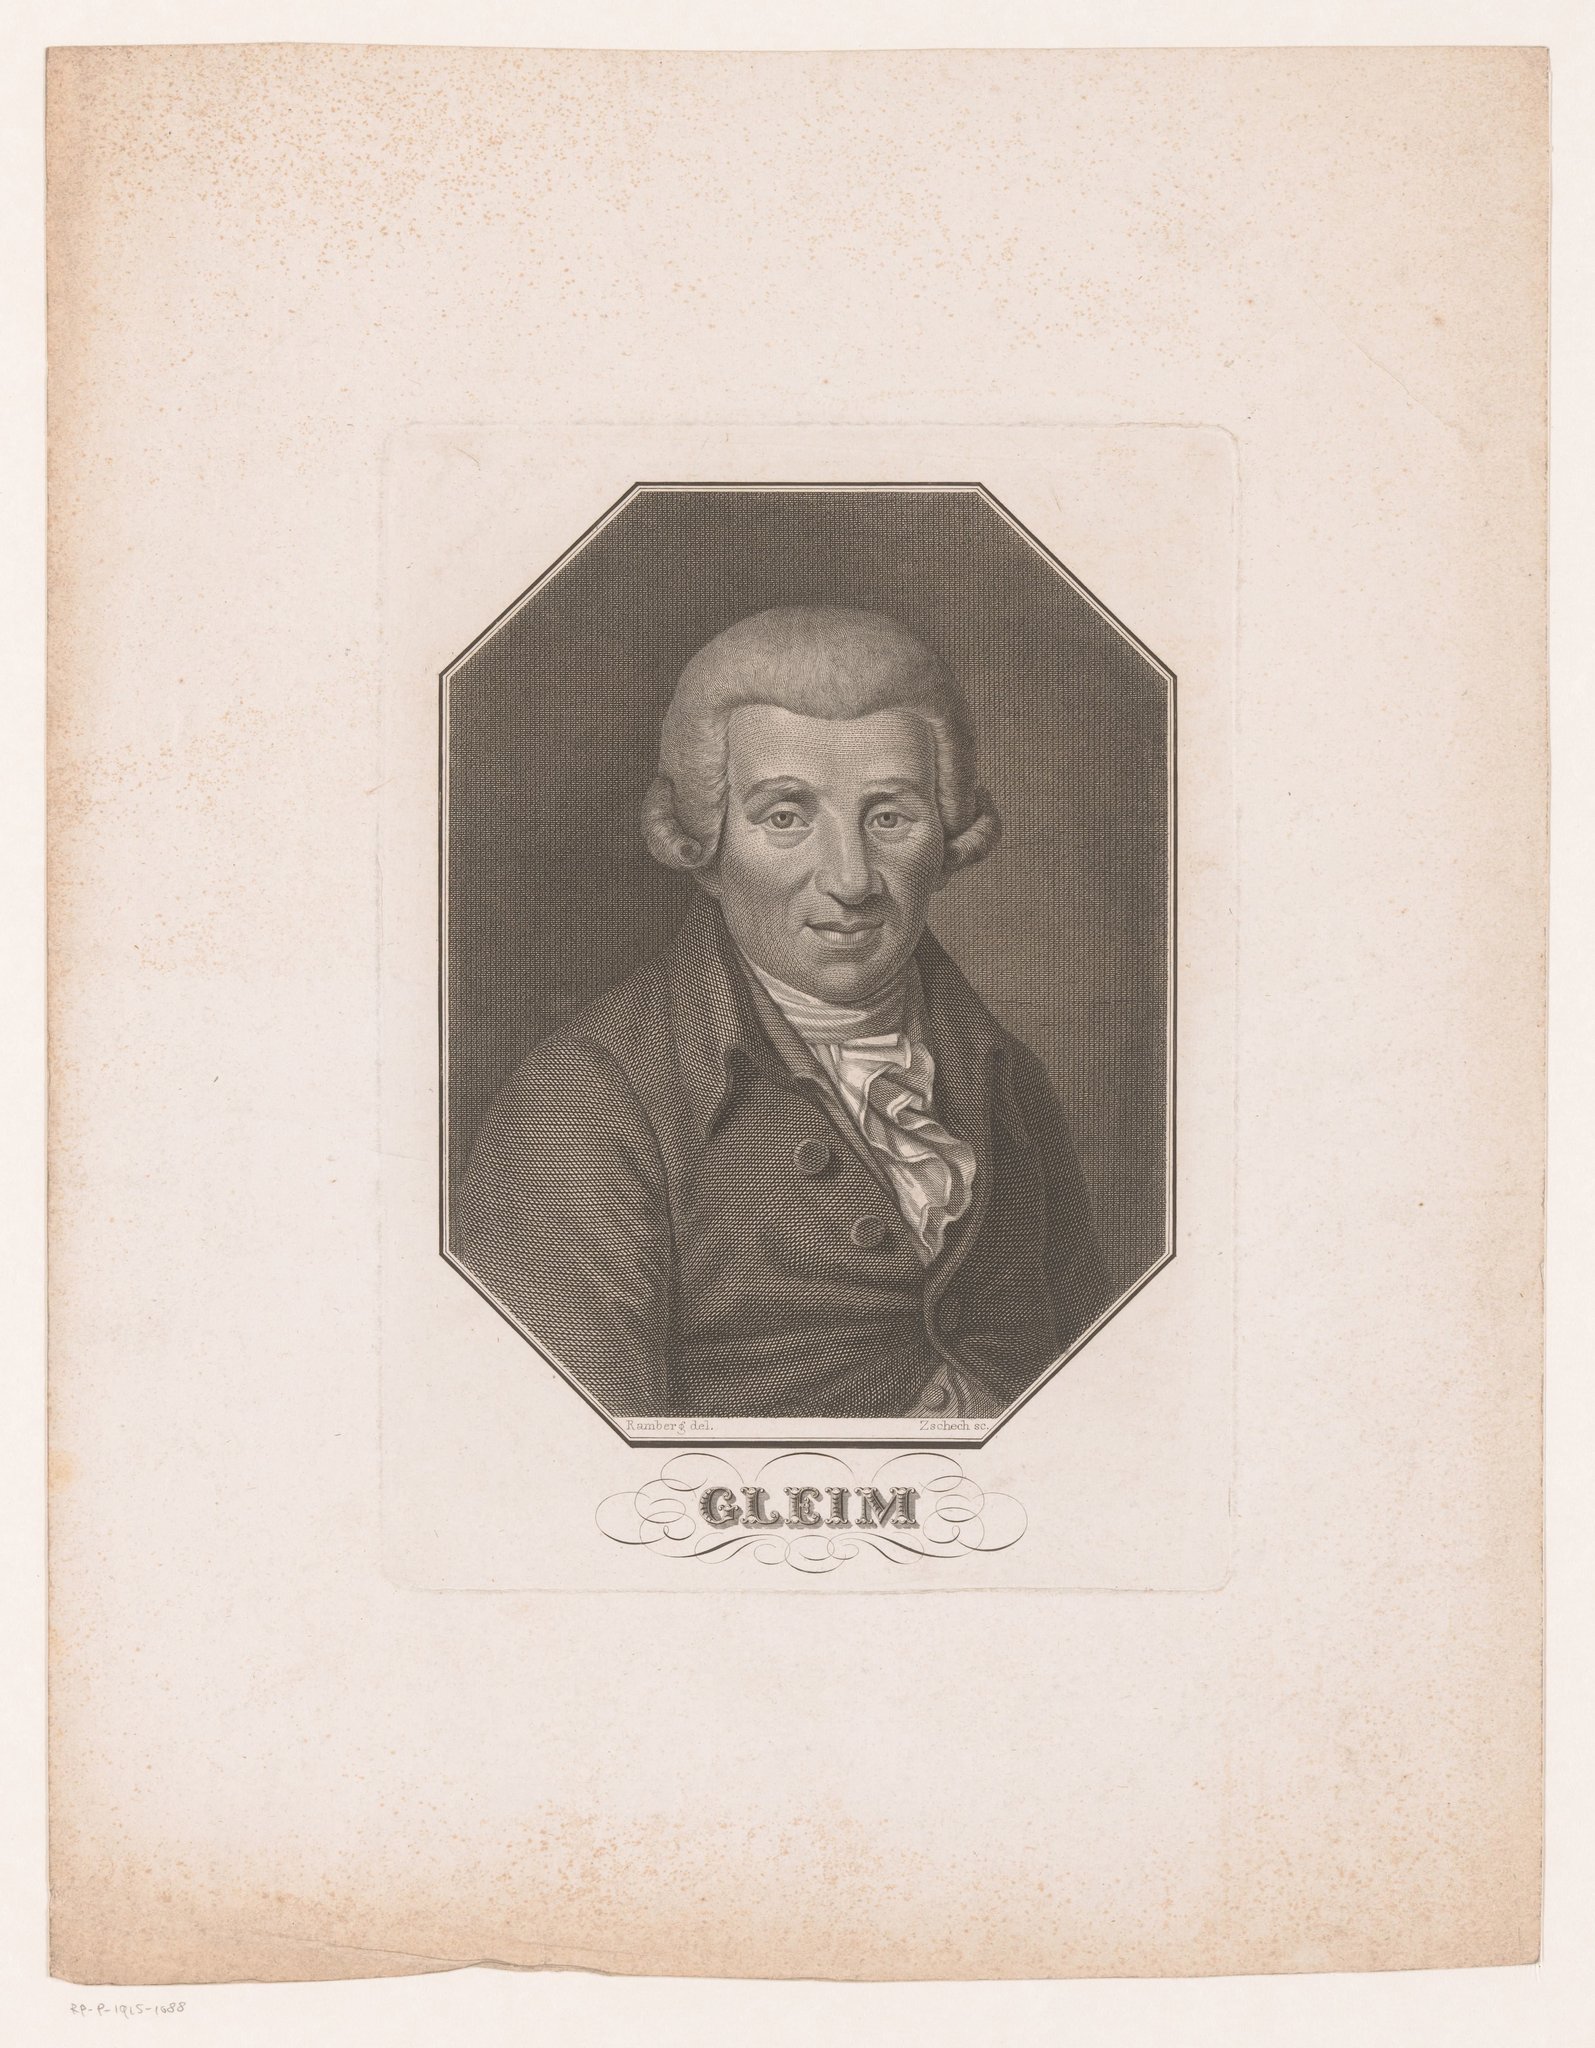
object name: print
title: Portret van Ludwig Gleim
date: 1785-1833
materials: paper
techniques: engraving, etching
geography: germany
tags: historical persons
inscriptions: collector's mark: Lugt 2228